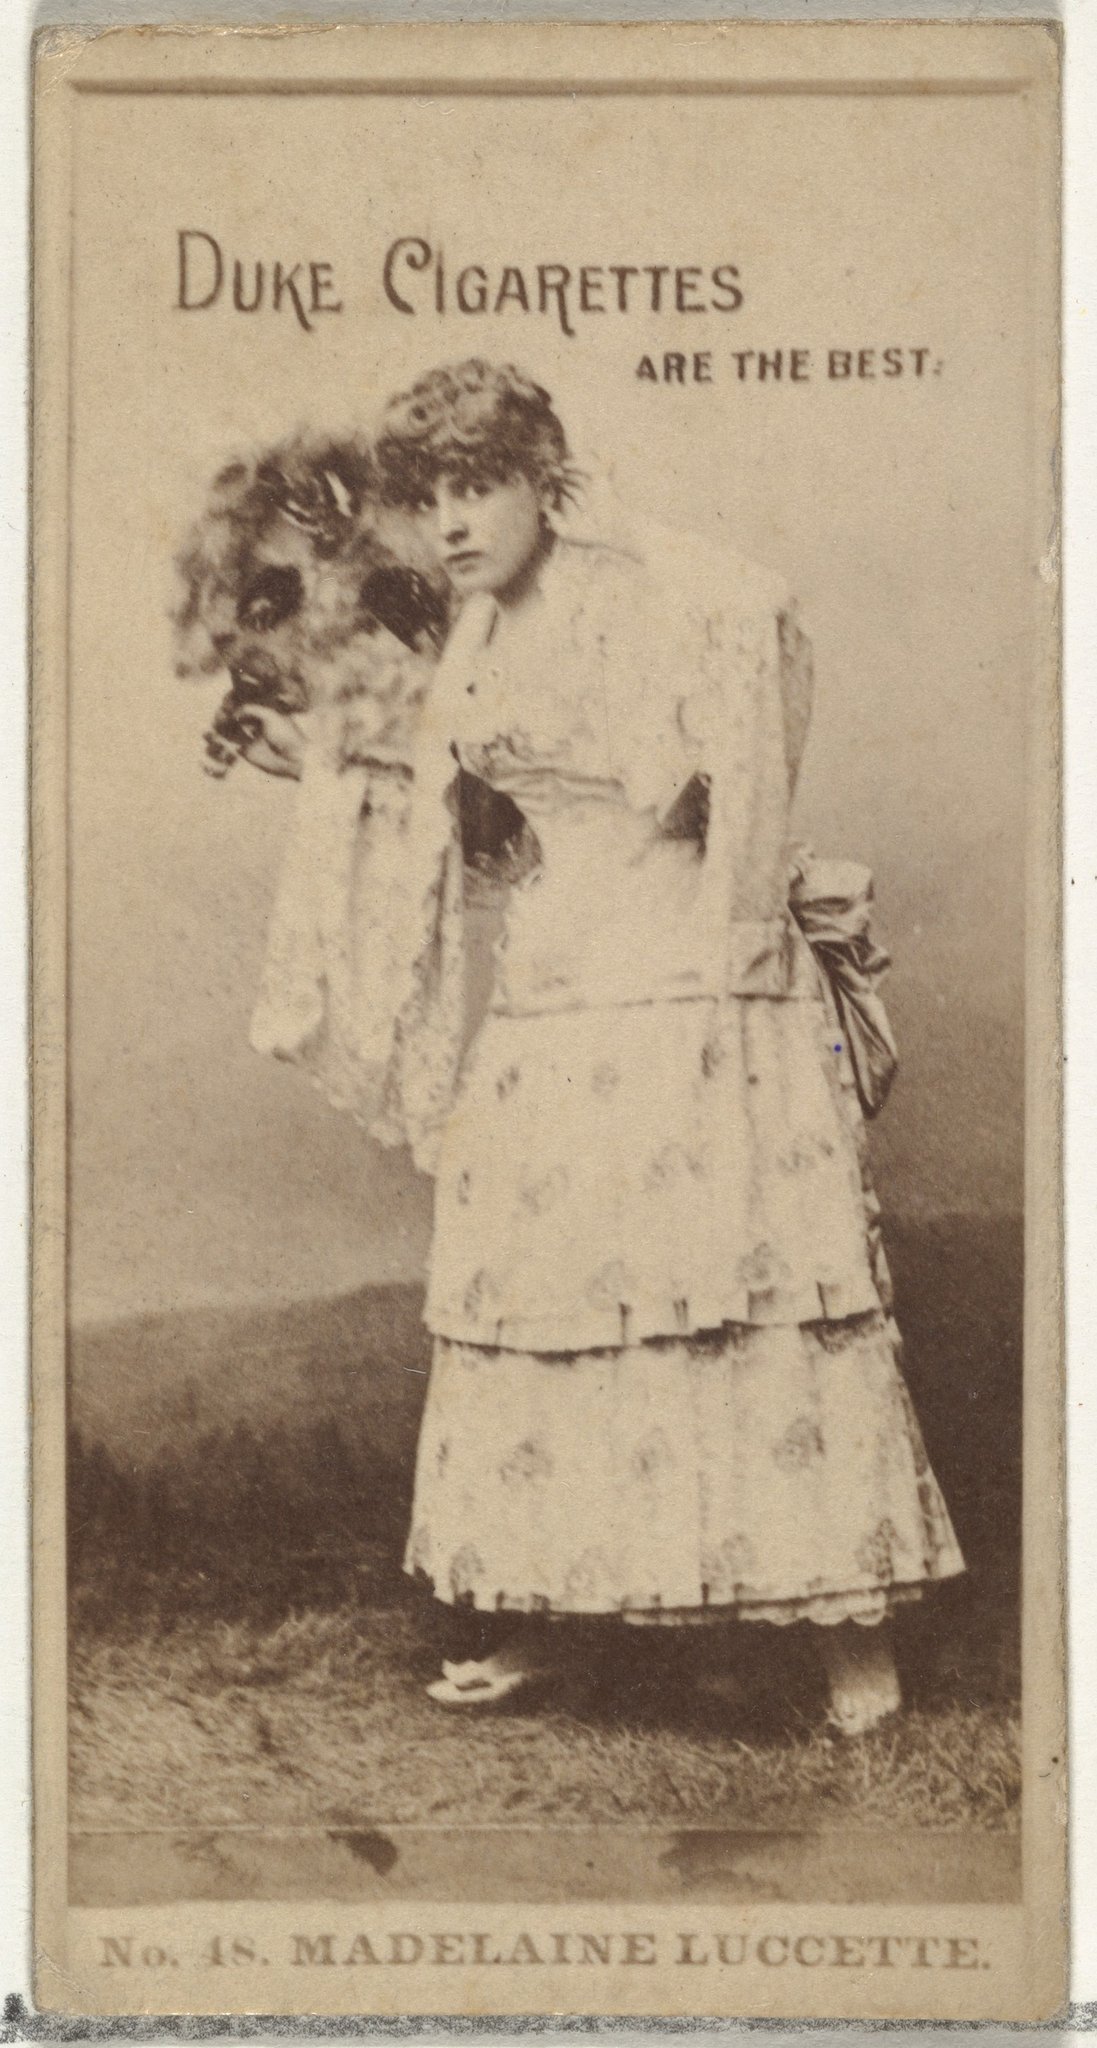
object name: photograph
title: Card Number 48, Madelaine Luccette, from the Actors and Actresses series (N145-6) issued by Duke Sons & Co. to promote Duke Cigarettes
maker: w. duke, sons & co.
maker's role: publisher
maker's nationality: american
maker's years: 1870-1920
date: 1880-1889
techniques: albumen silver print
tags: portraits,women,actresses